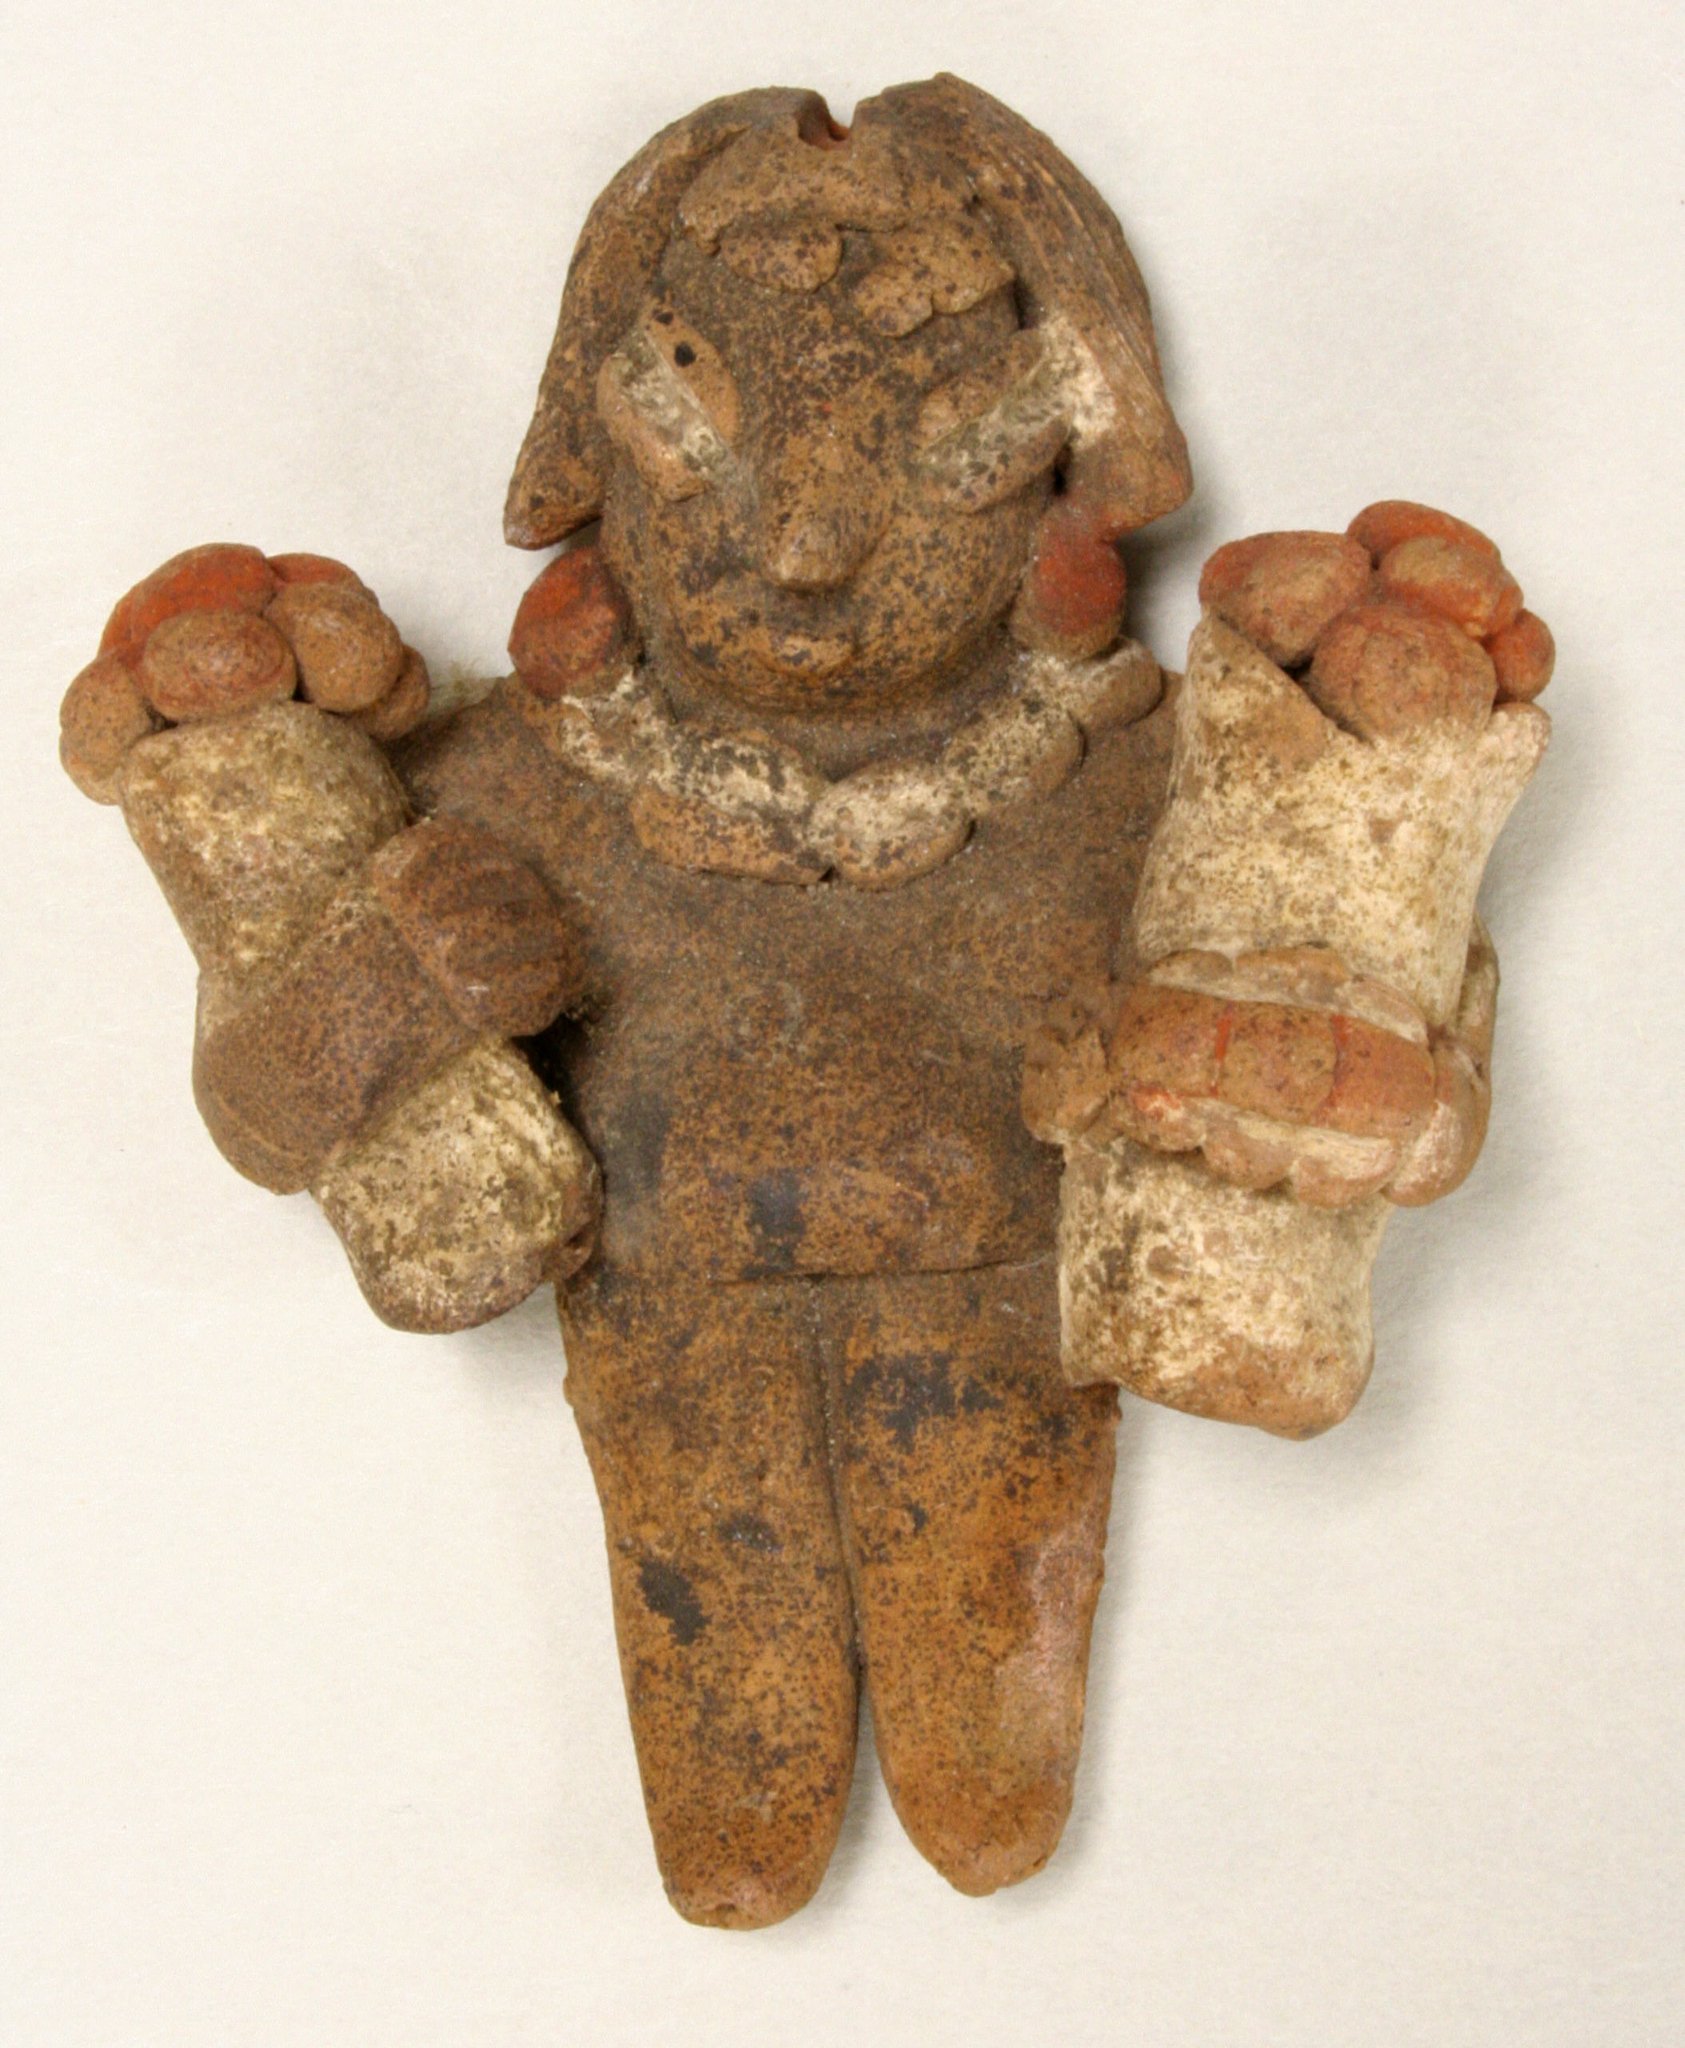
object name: female figure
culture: chupicuaro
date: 300 BCE-400 CE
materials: ceramic, pigment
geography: mexico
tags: women